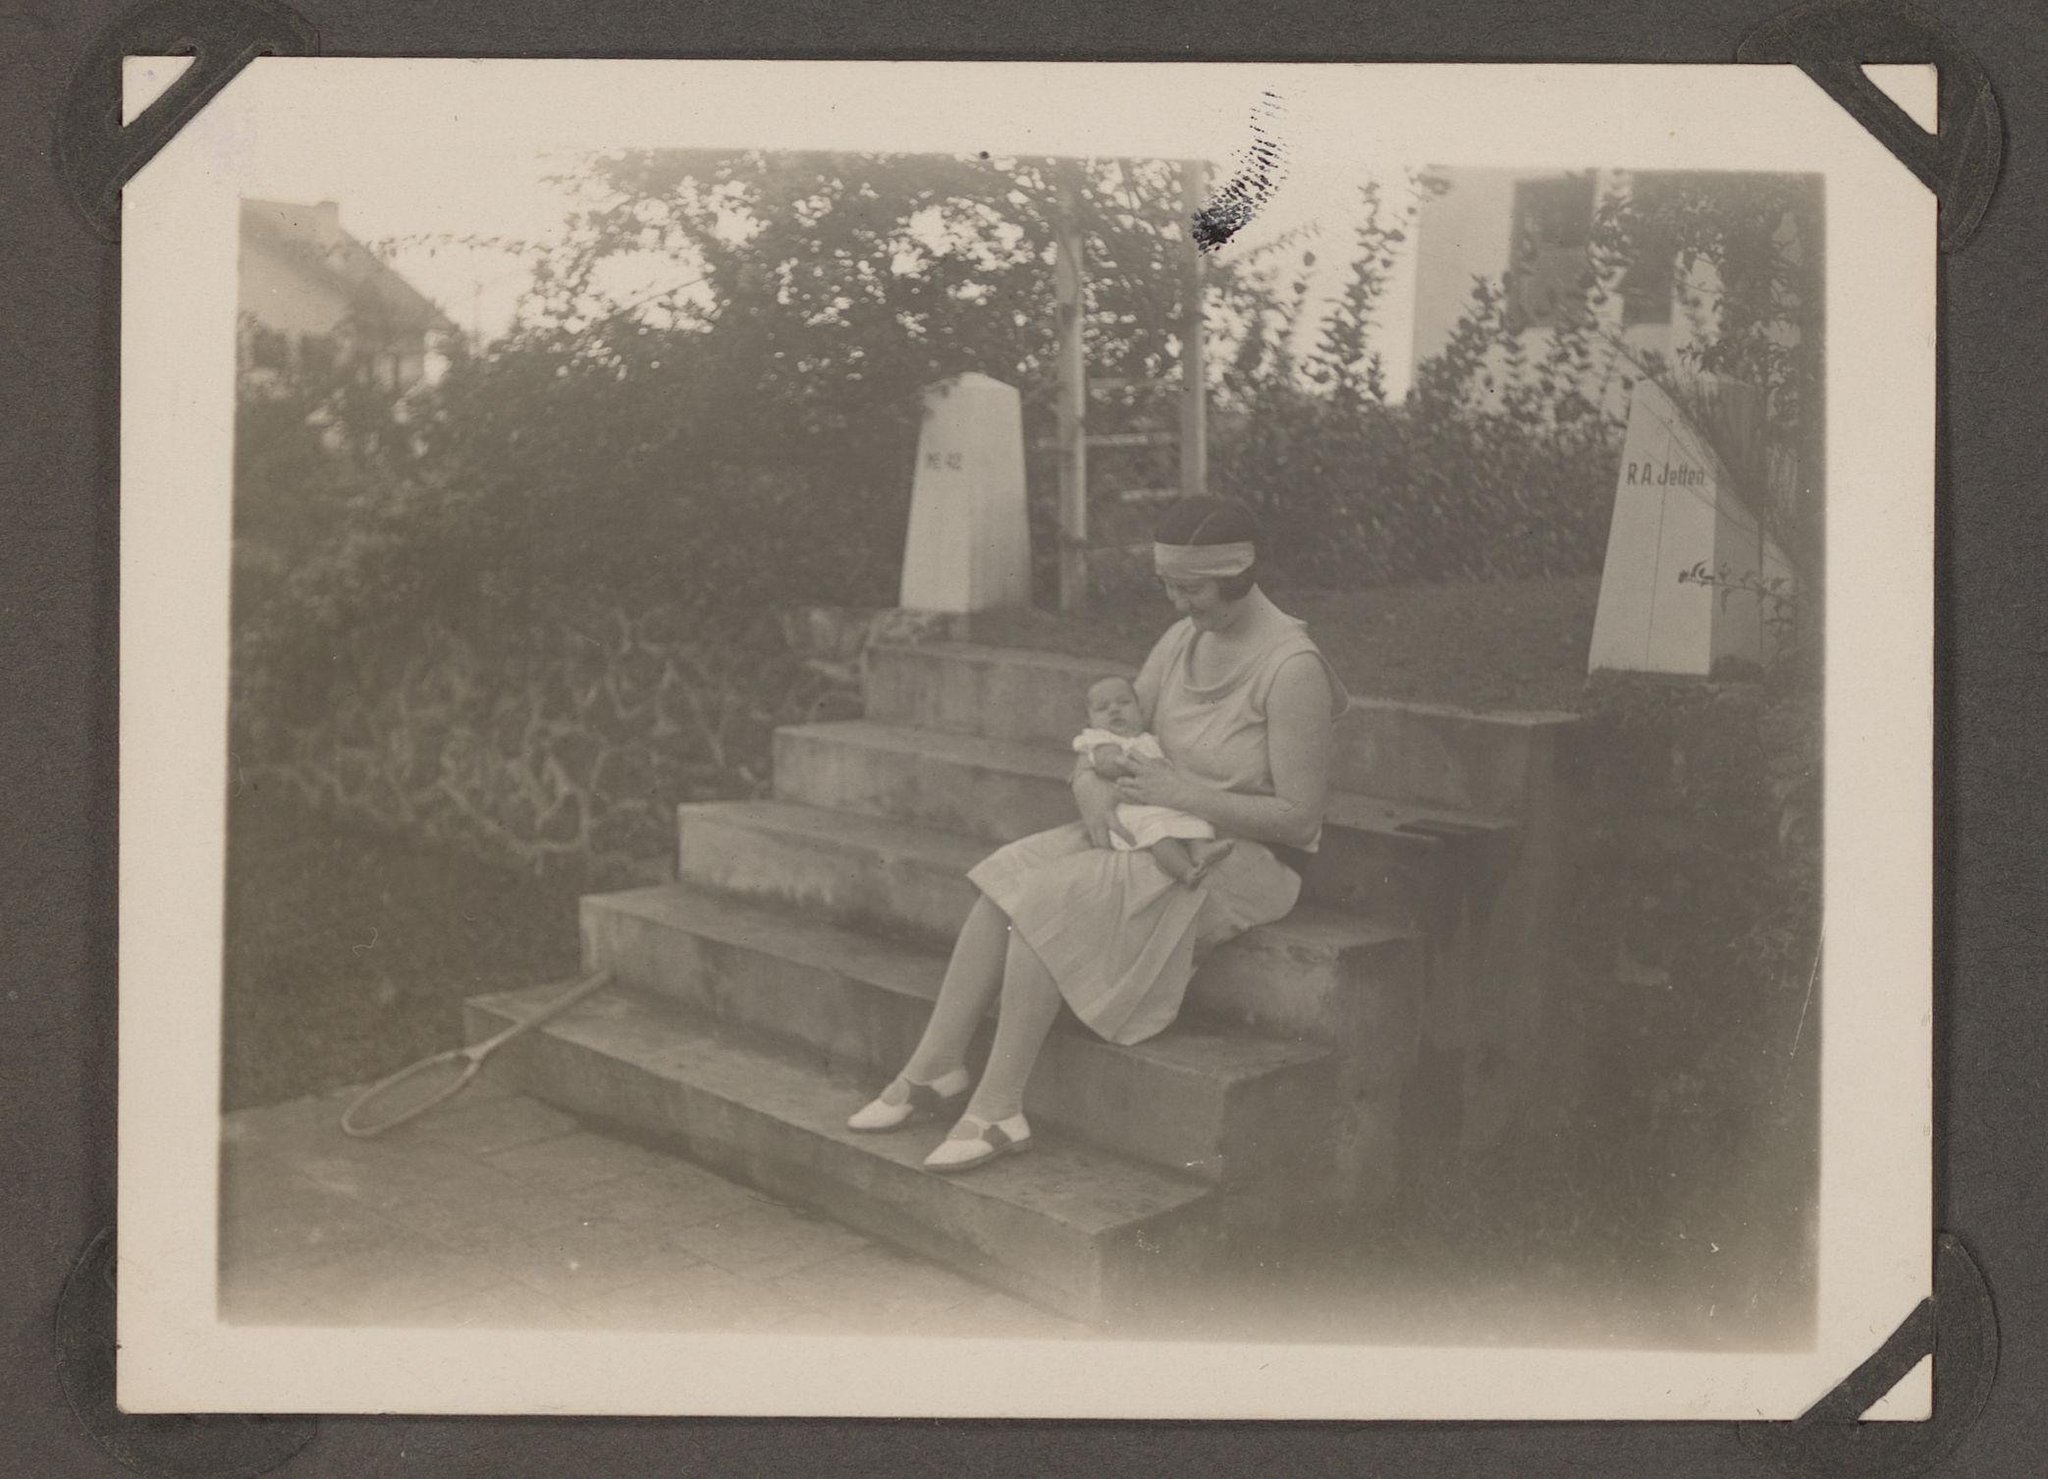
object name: photograph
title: Familiefoto van het gezin Jetten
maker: Anonymous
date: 1925-1927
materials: photographic support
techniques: photography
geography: suriname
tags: jetten, familie, moengo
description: Familiefoto van de kinderen Jetten. Foto op een bladzijde van een los albumblad. Onderdeel van het ensemble met foto's van de familie van ingenieur Jetten in de mijnbouwstad Moengo in Suriname.